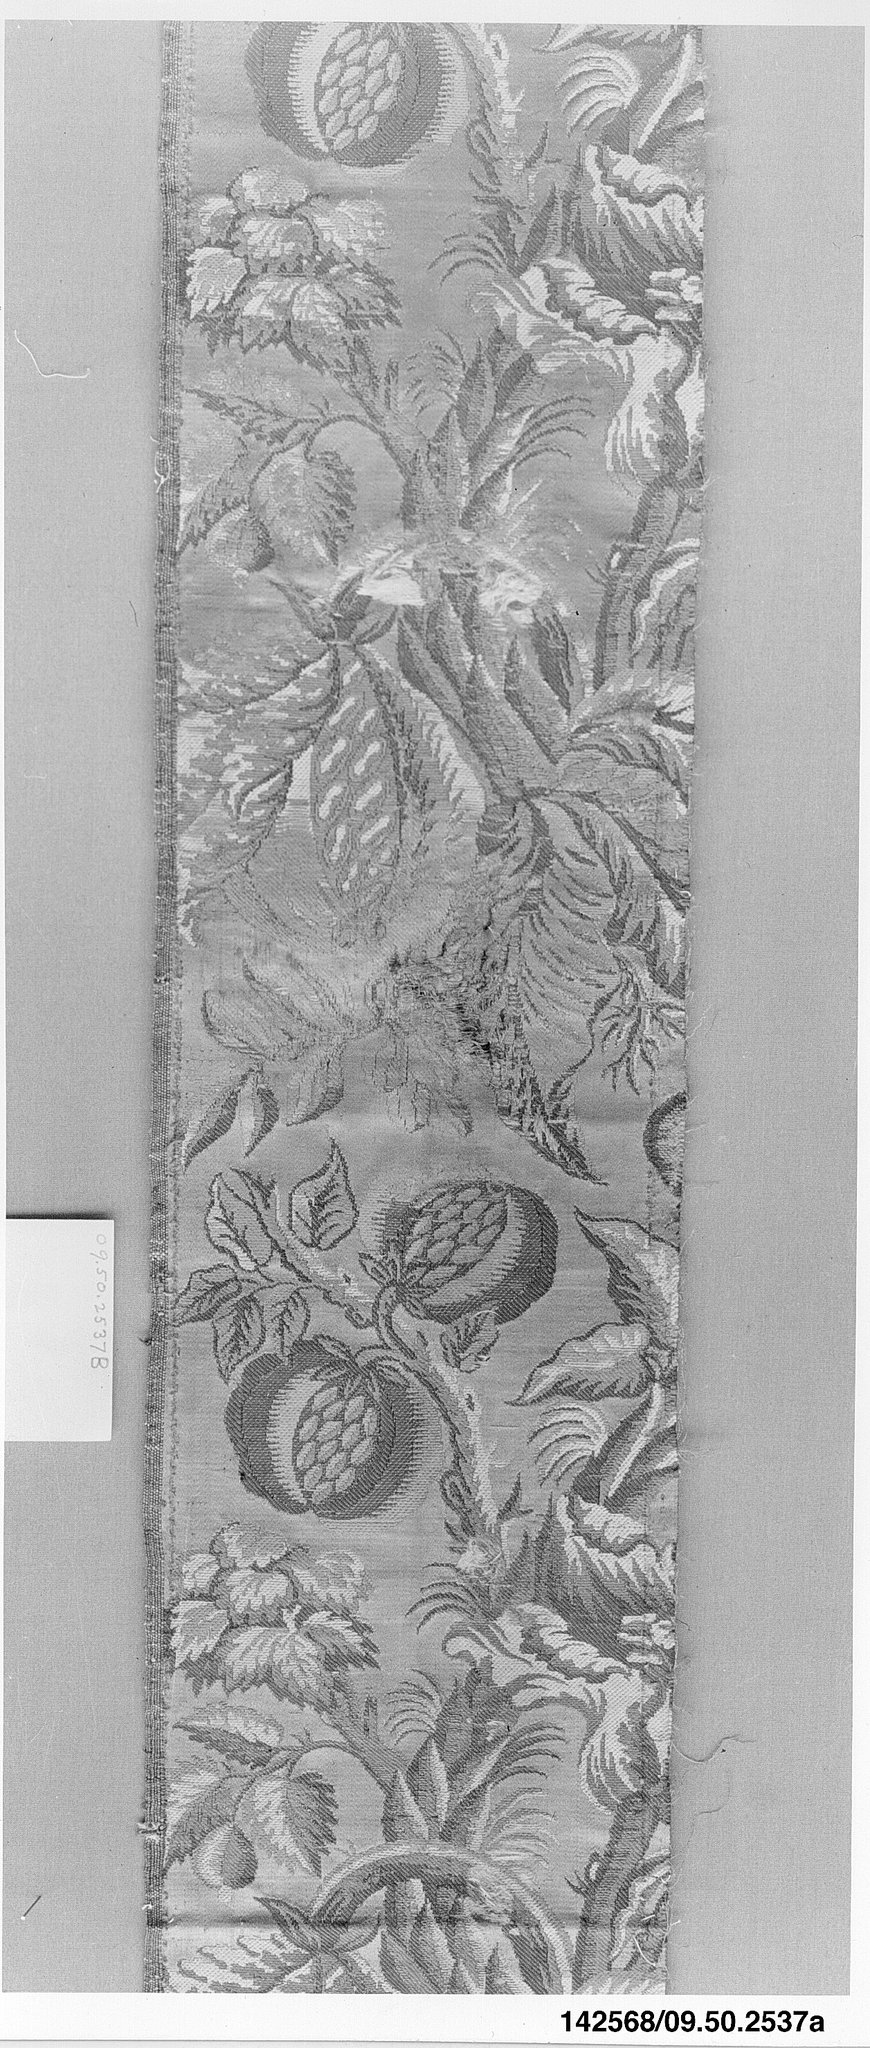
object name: piece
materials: silk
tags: flowers,leaves